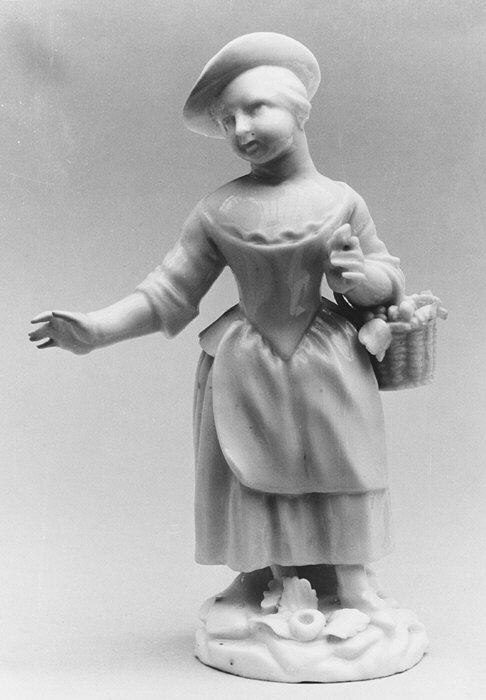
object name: figure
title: Gardener (one of a pair)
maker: crépy-en-valois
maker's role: factory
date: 1765-1770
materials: soft paste porcelain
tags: women,gardeners